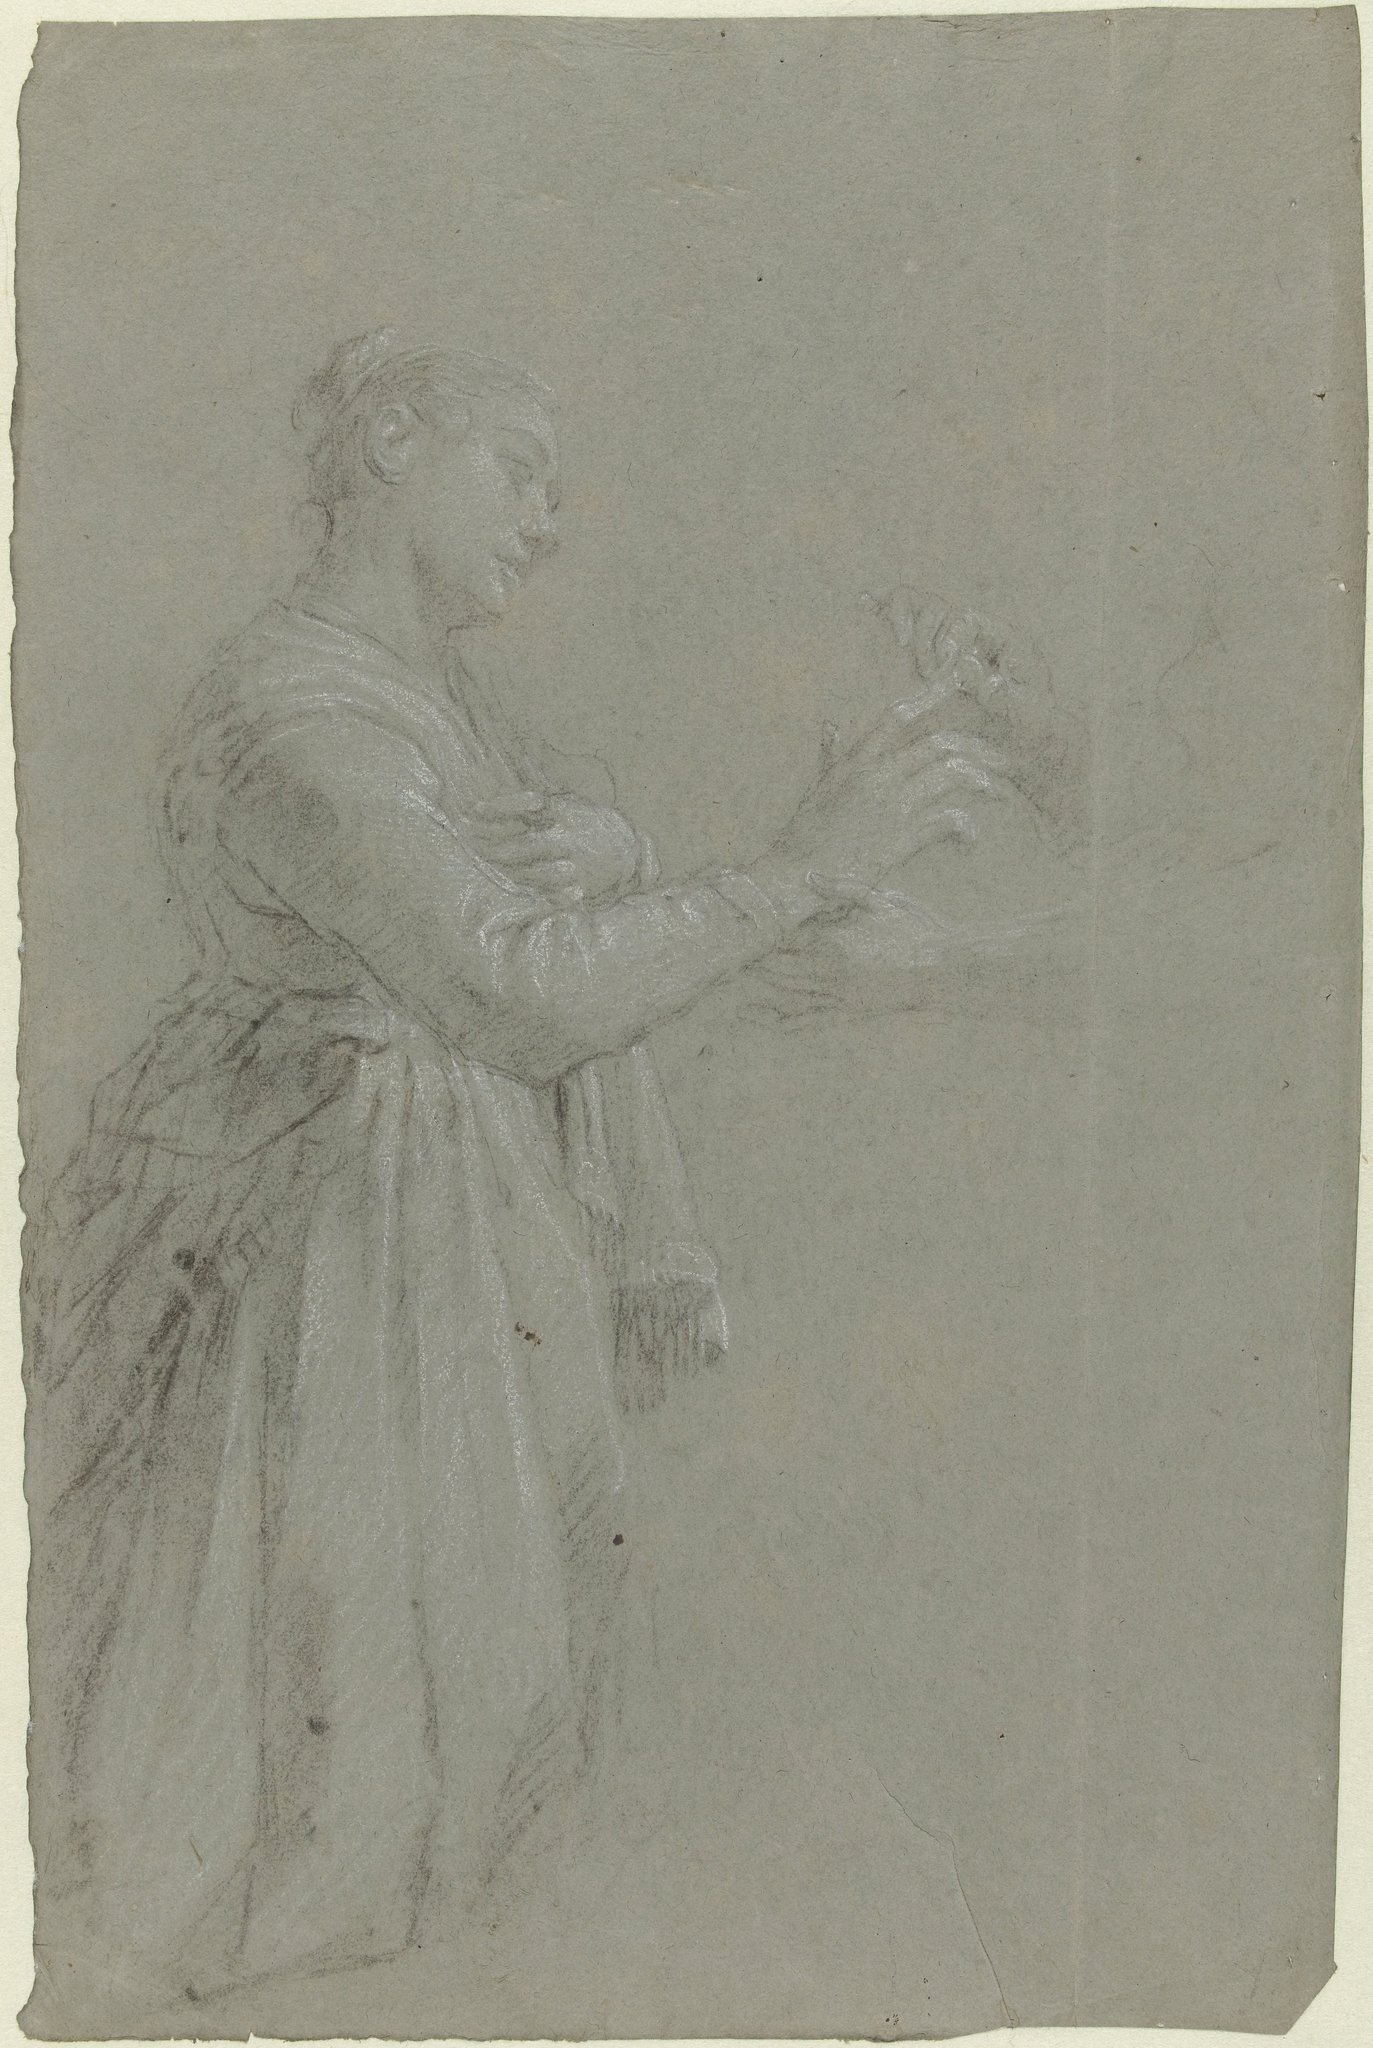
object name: drawing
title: De heilige Catharina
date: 1600-1699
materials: chalk, paper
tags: kneeling figure - aa - female human figure, the mystic marriage of st. catherine of alexandria with the infant christ: the christ-child puts a ring on her finger